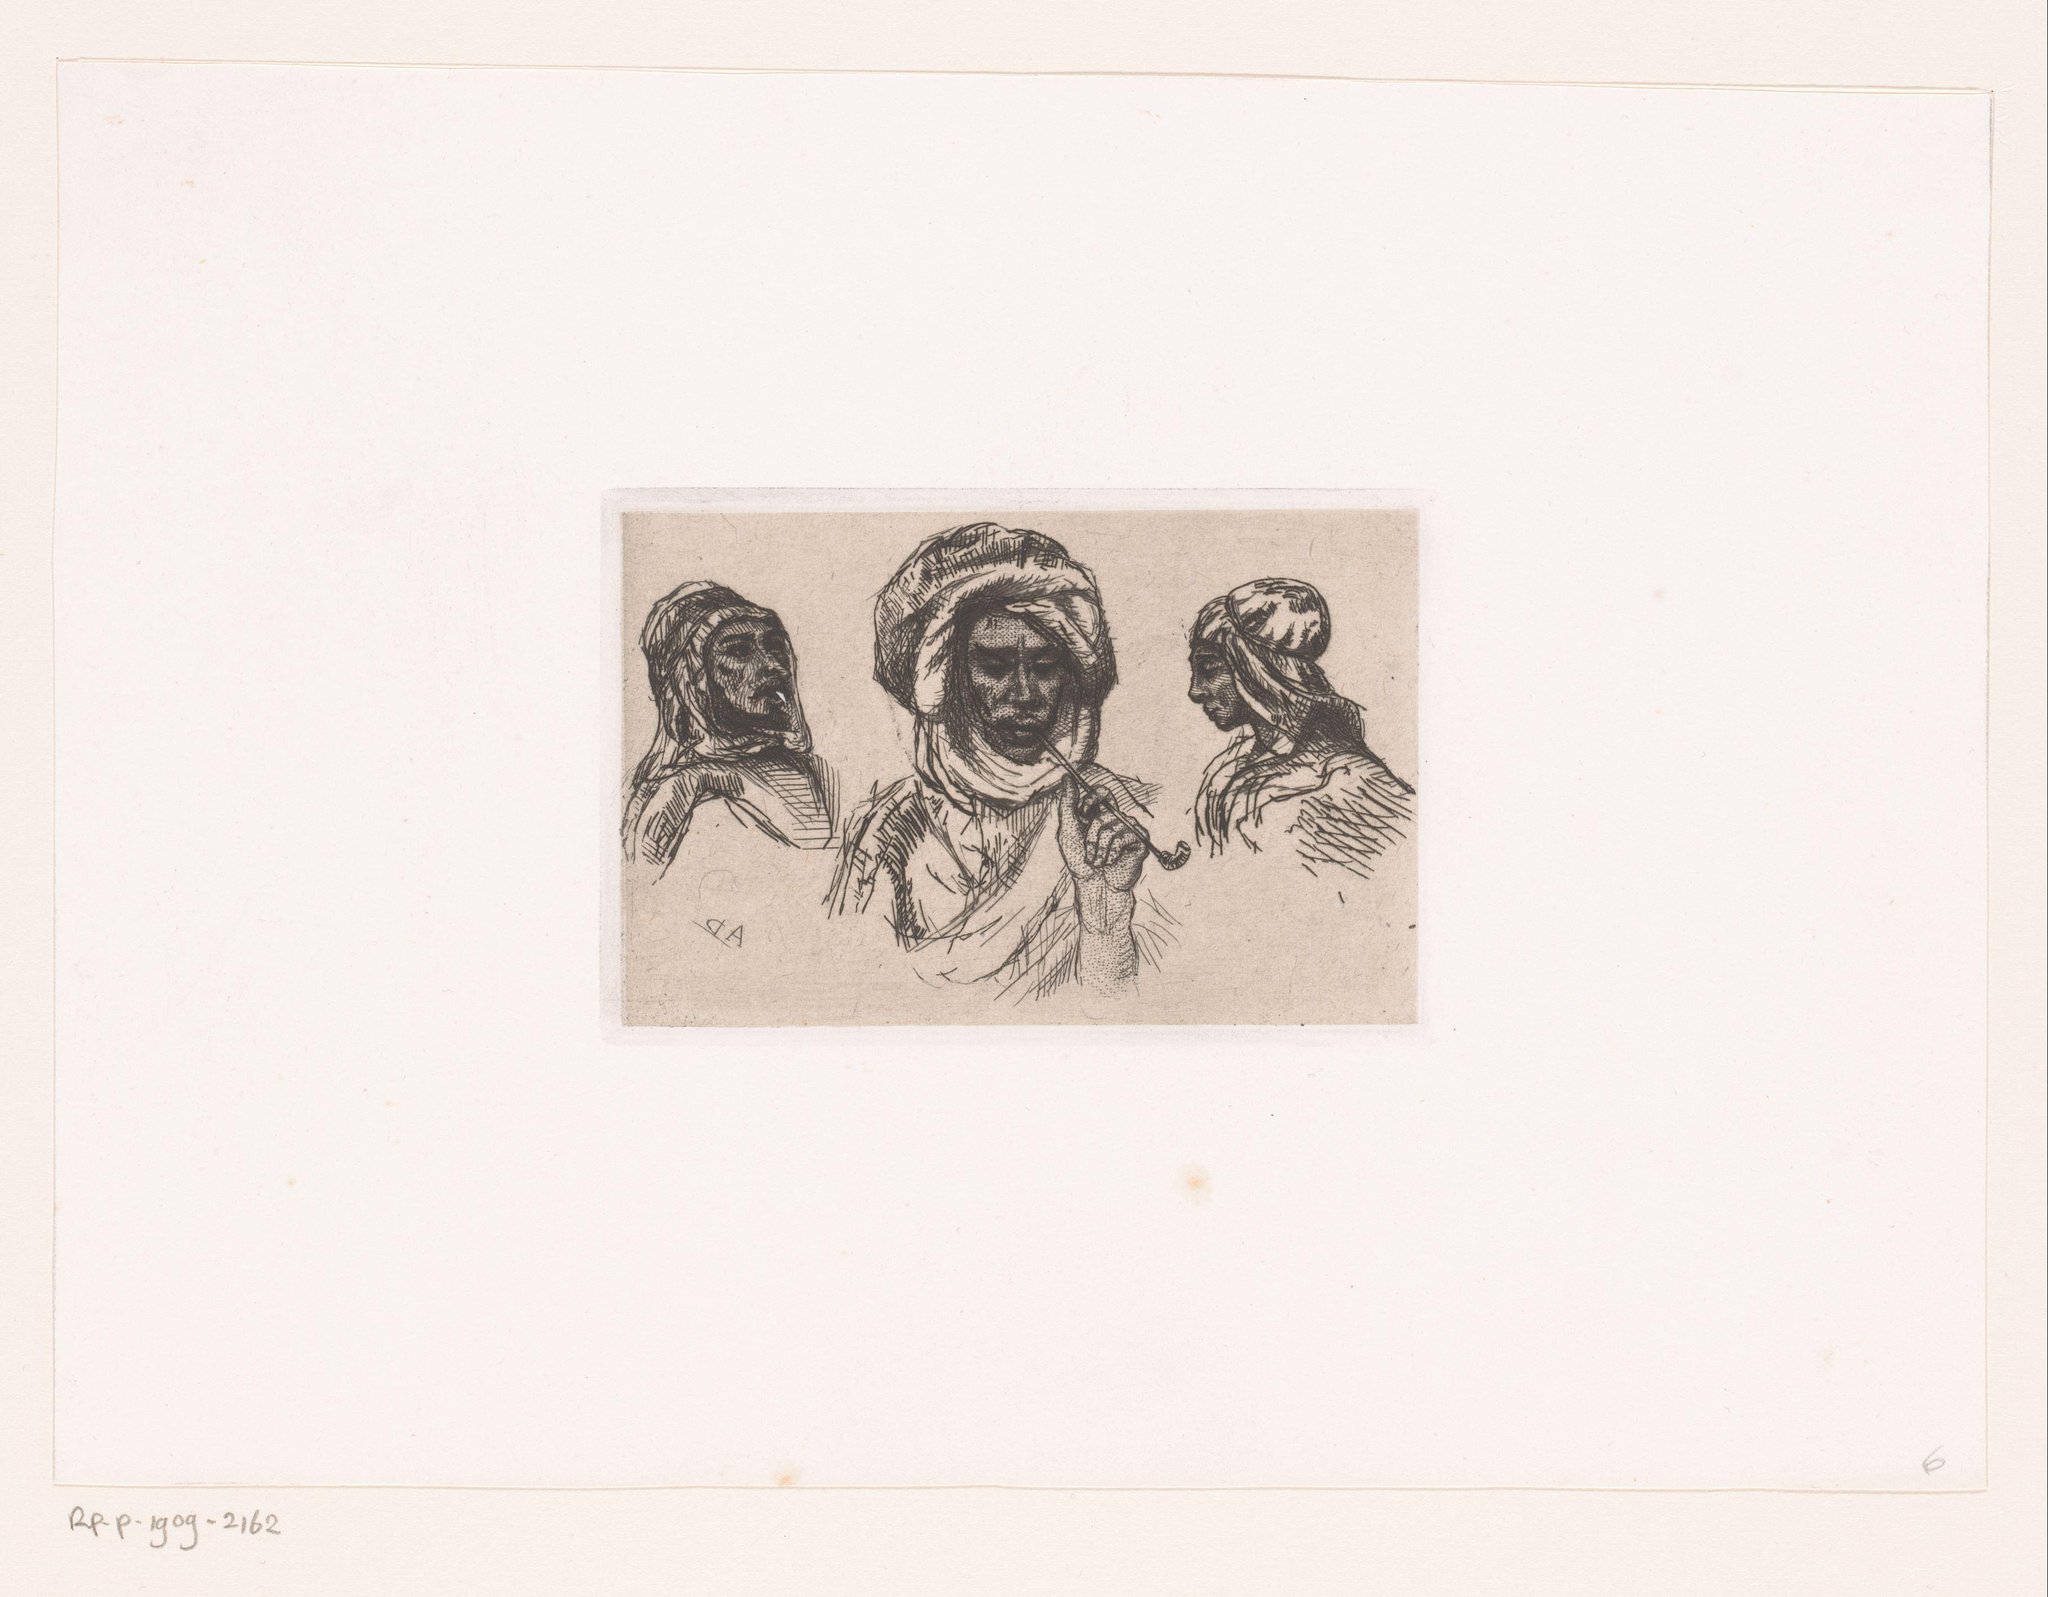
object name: print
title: Drie figuren met een hoofddoek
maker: vicomte arthur-jean le bailly dinghuem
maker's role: print maker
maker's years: 1839-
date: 1875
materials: paper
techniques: etching, intaglio, roulette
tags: adult man (+ two persons), adult woman, head-gear, pipe ~ tobacco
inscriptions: collector's mark: Lugt 2228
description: Onderdeel van een serie van twaalf prenten.